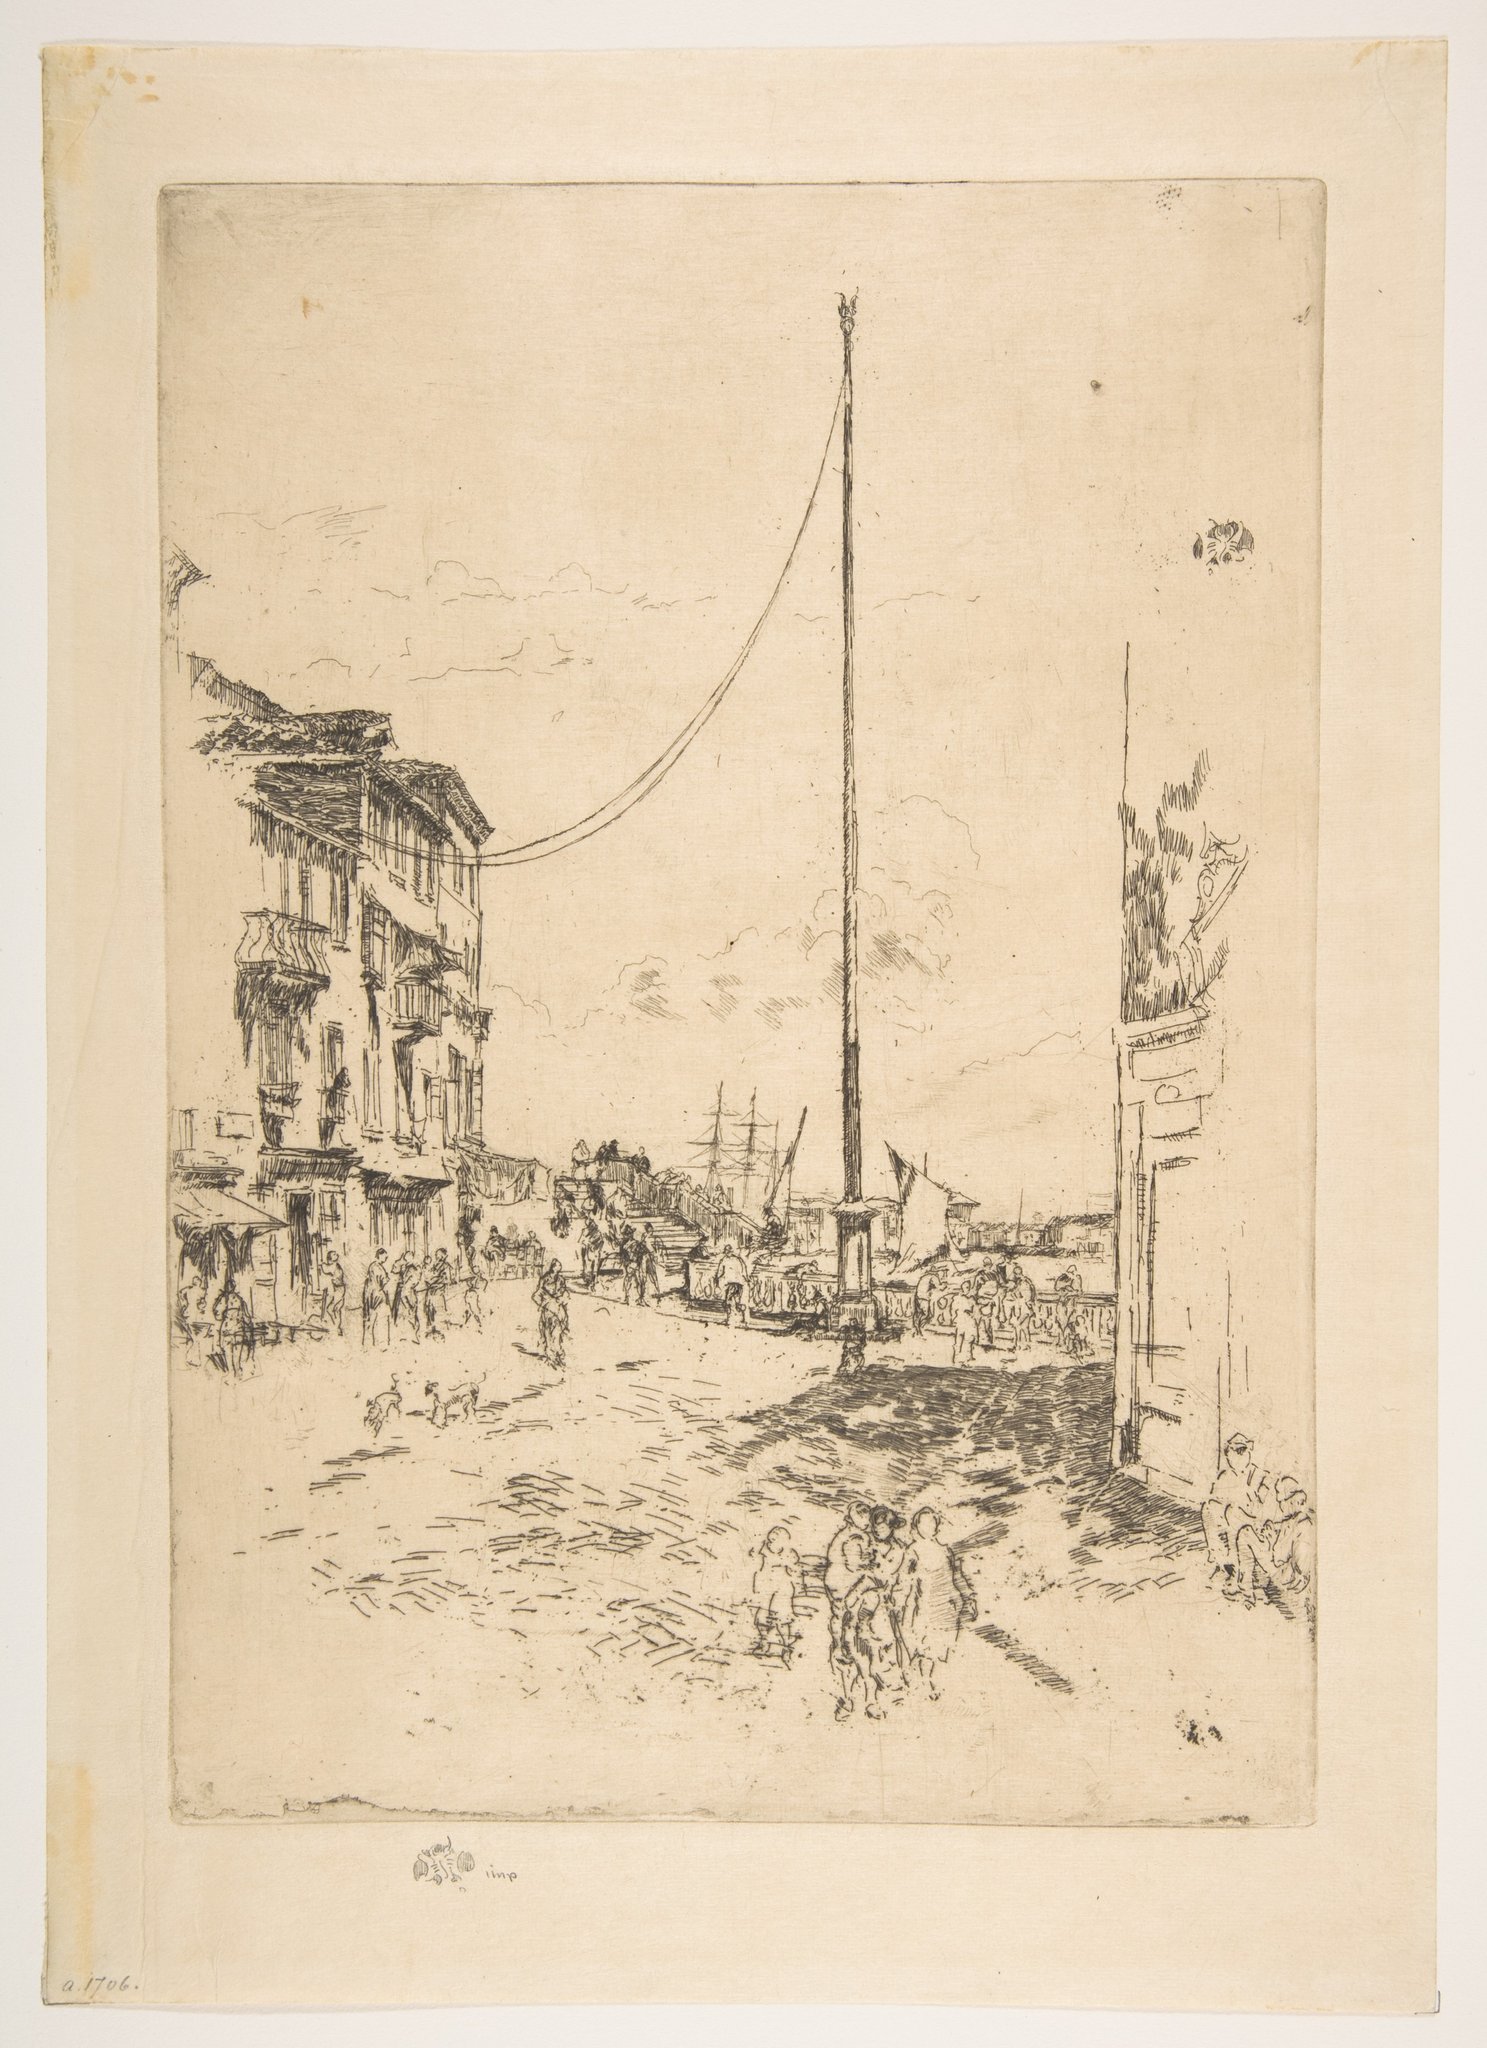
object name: print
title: The Little Mast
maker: james mcneill whistler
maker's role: artist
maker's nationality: american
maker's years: 1834-1903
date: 1879-1880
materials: ink, ivory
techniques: drypoint, etching, printing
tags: buildings,streets,venice